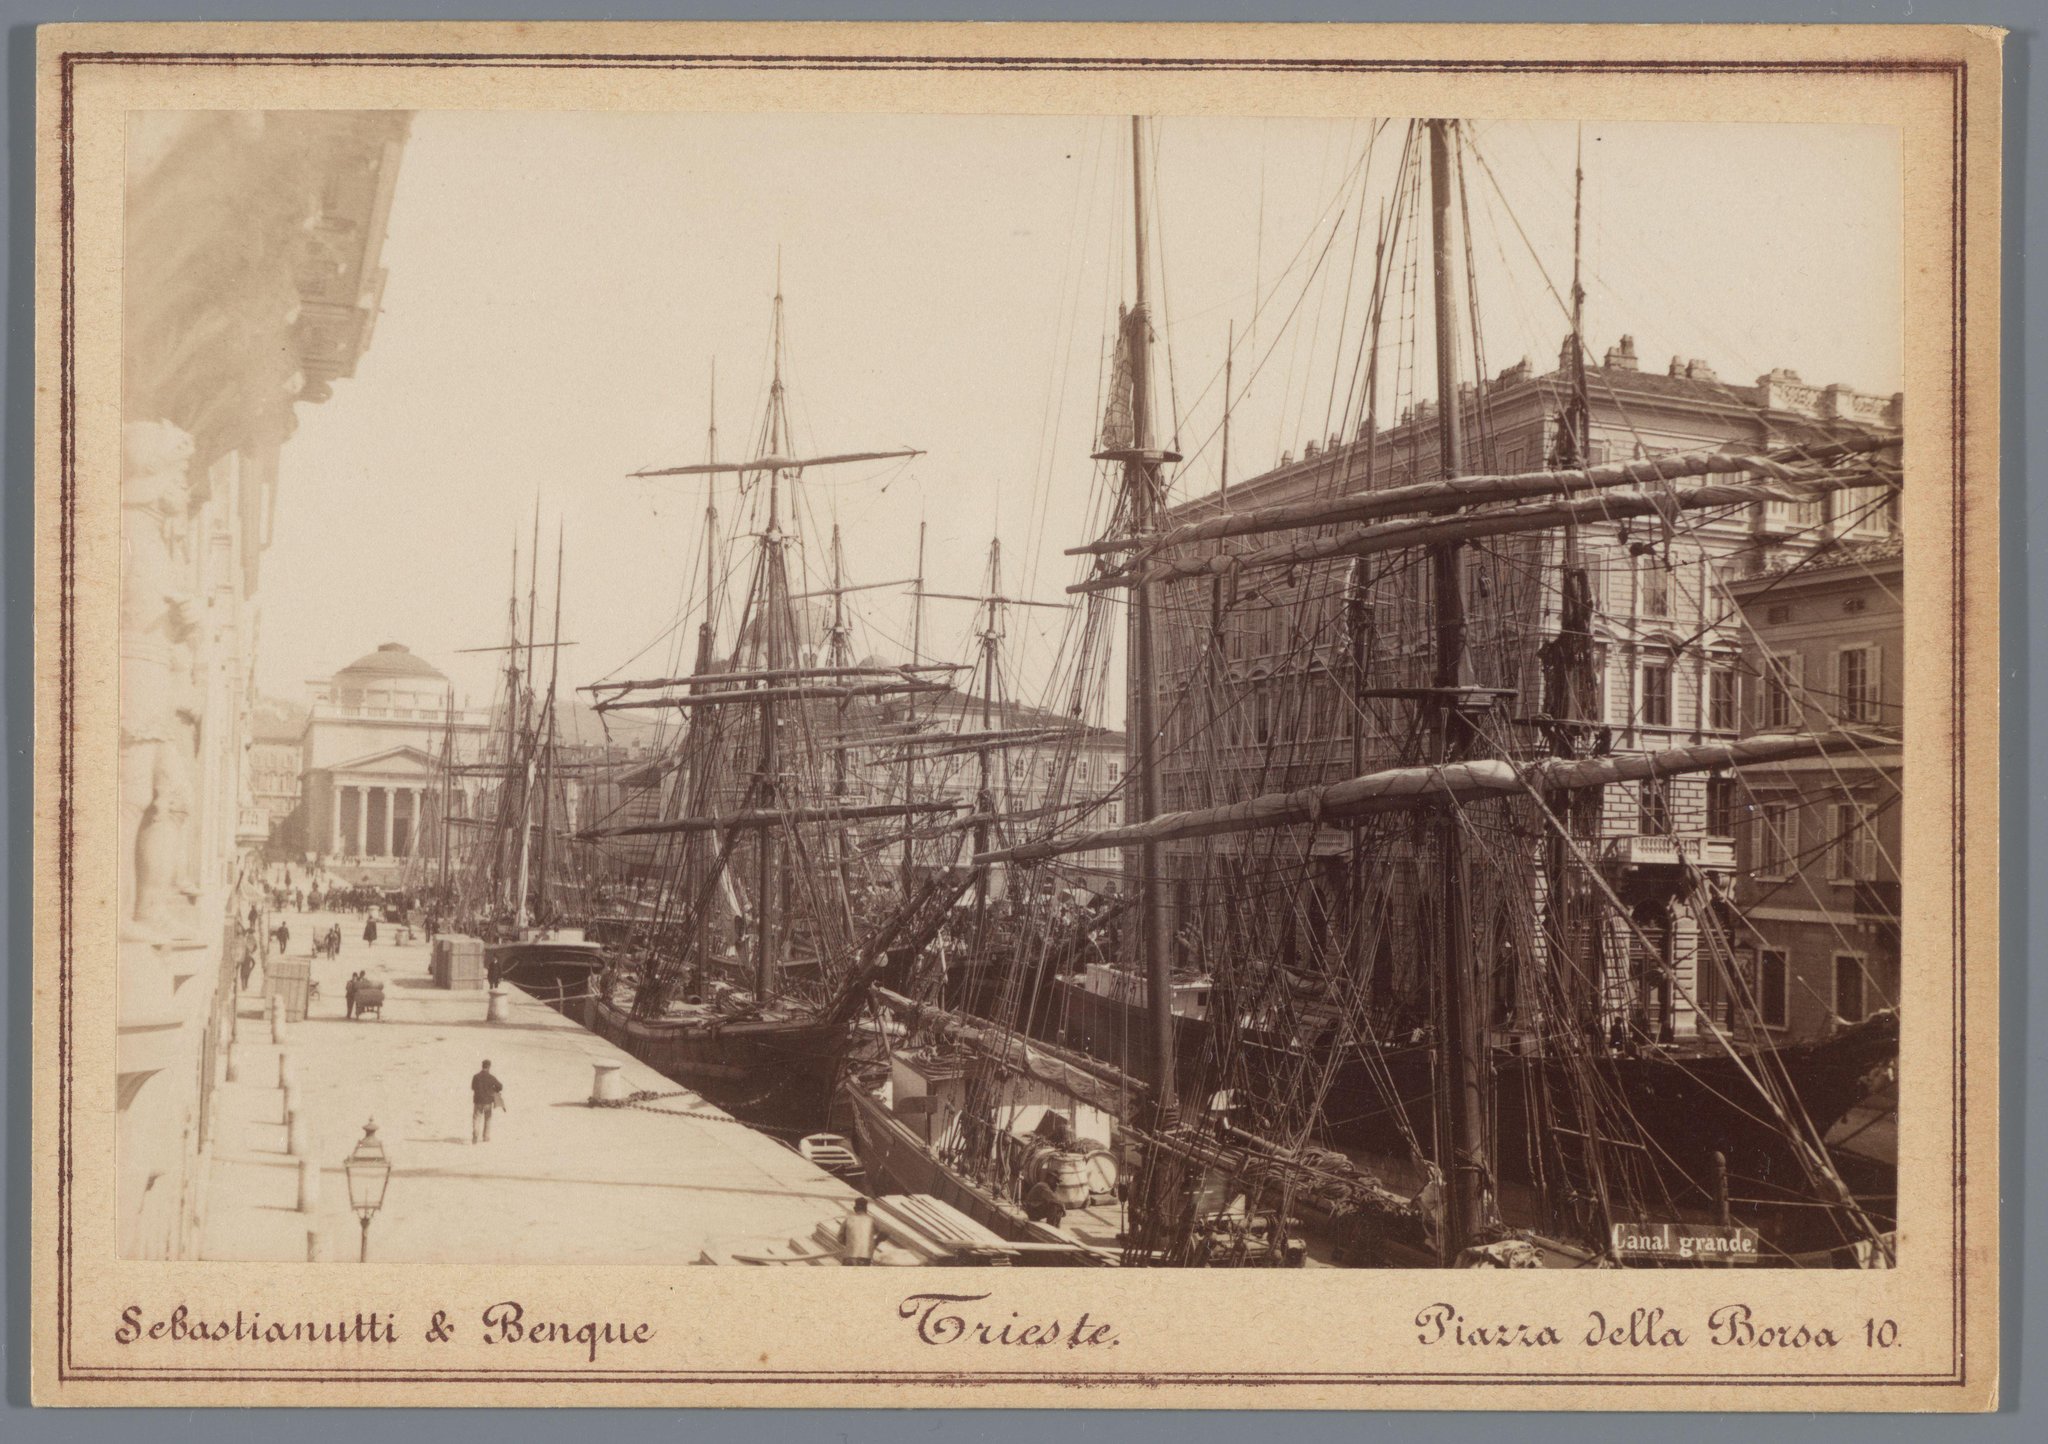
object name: cabinet photograph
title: Gezicht op schepen in Canal Grande in Trieste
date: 1885-1900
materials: photographic support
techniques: albumen print